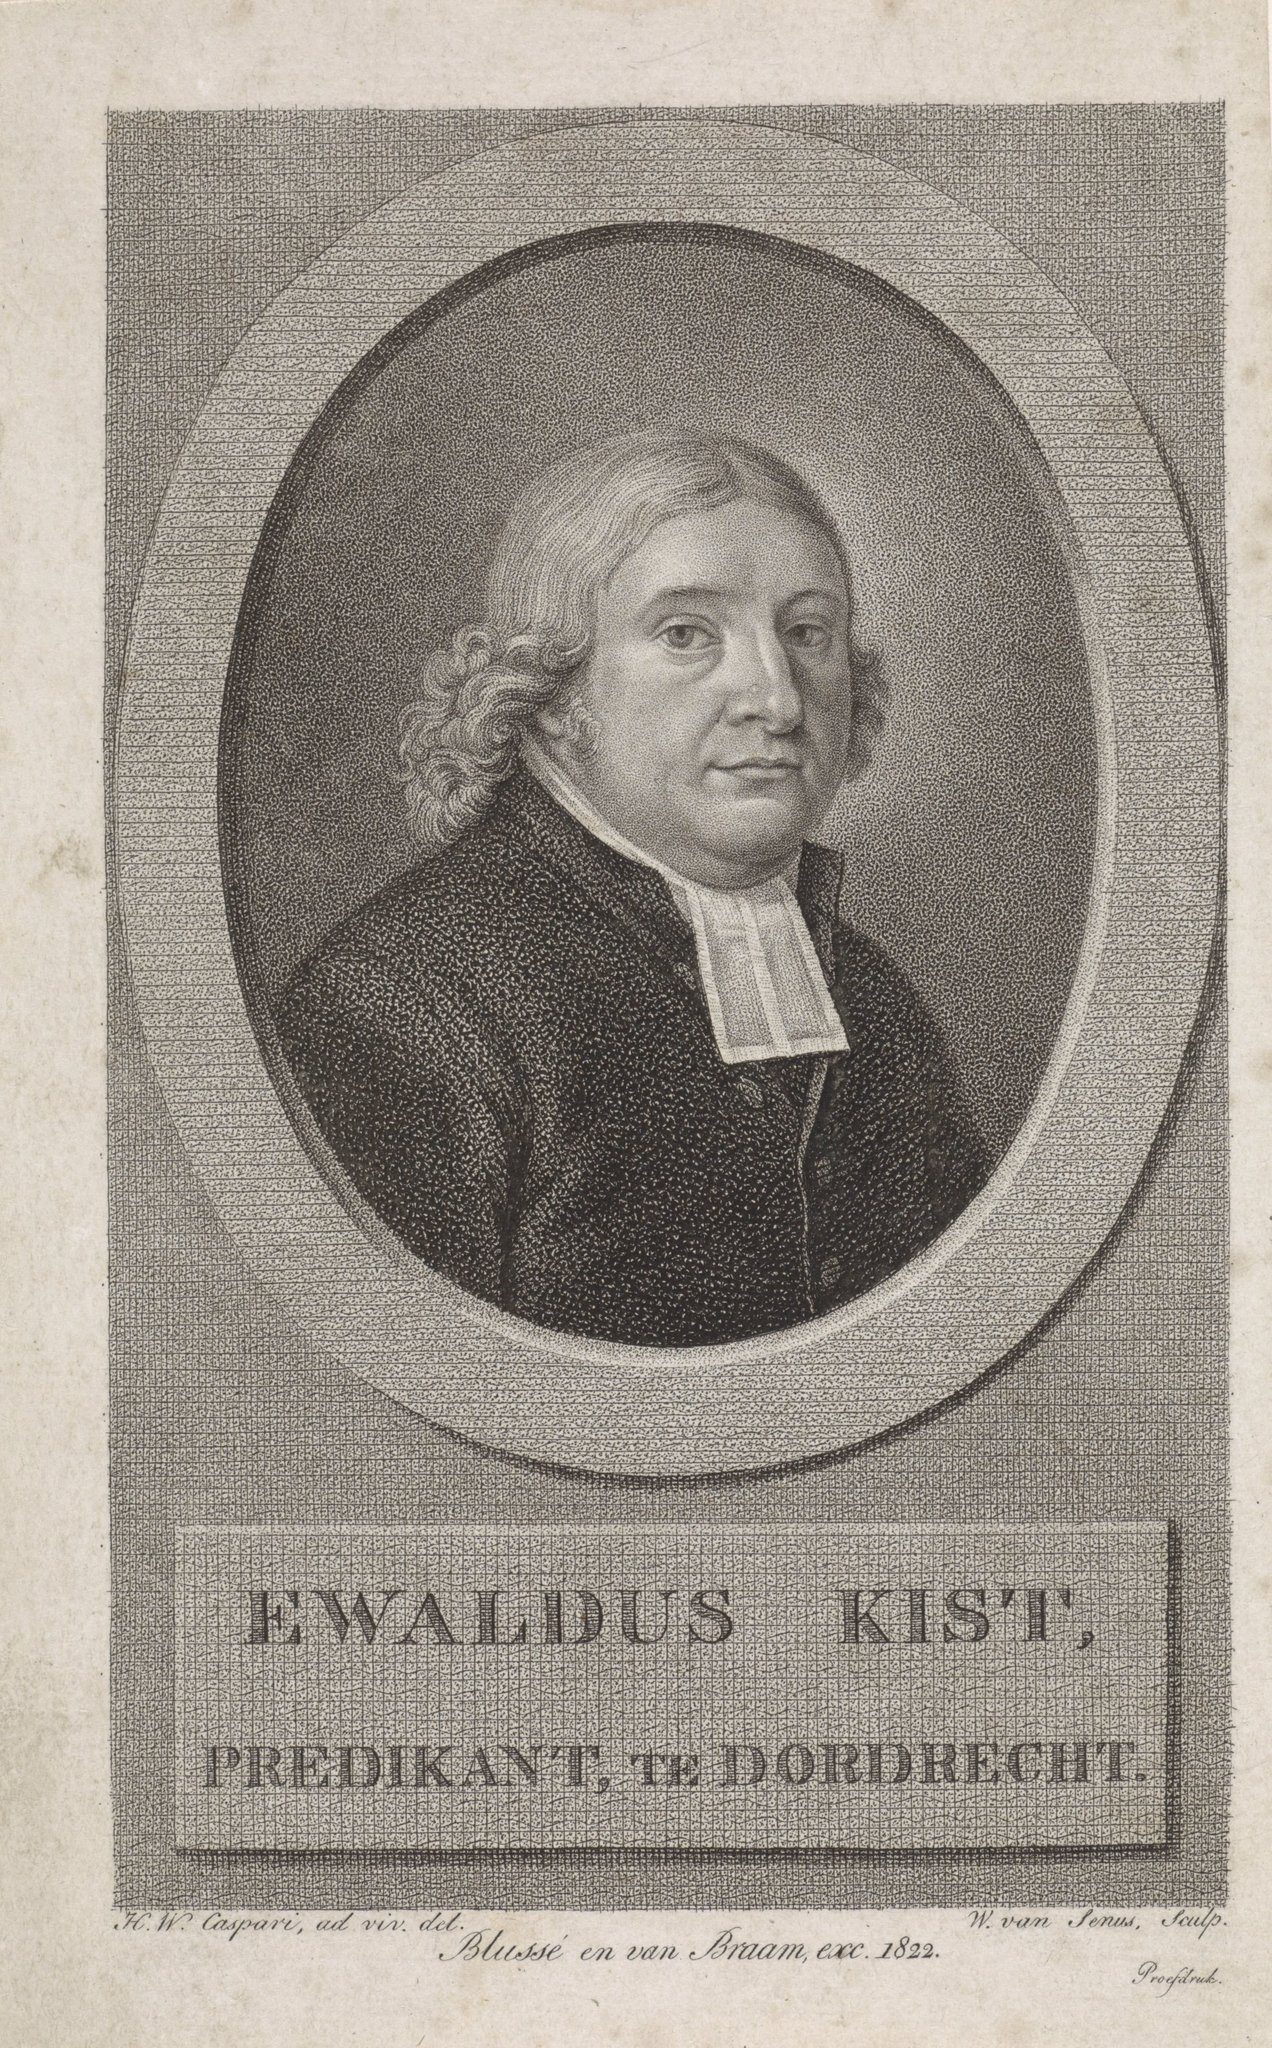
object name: print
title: Portret van Ewaldus Kist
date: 1822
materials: paper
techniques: etching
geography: amsterdam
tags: ewaldus kist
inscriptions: collector's mark: Lugt 2228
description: Portret van Ewaldus Kist, predikant te Rotterdam.